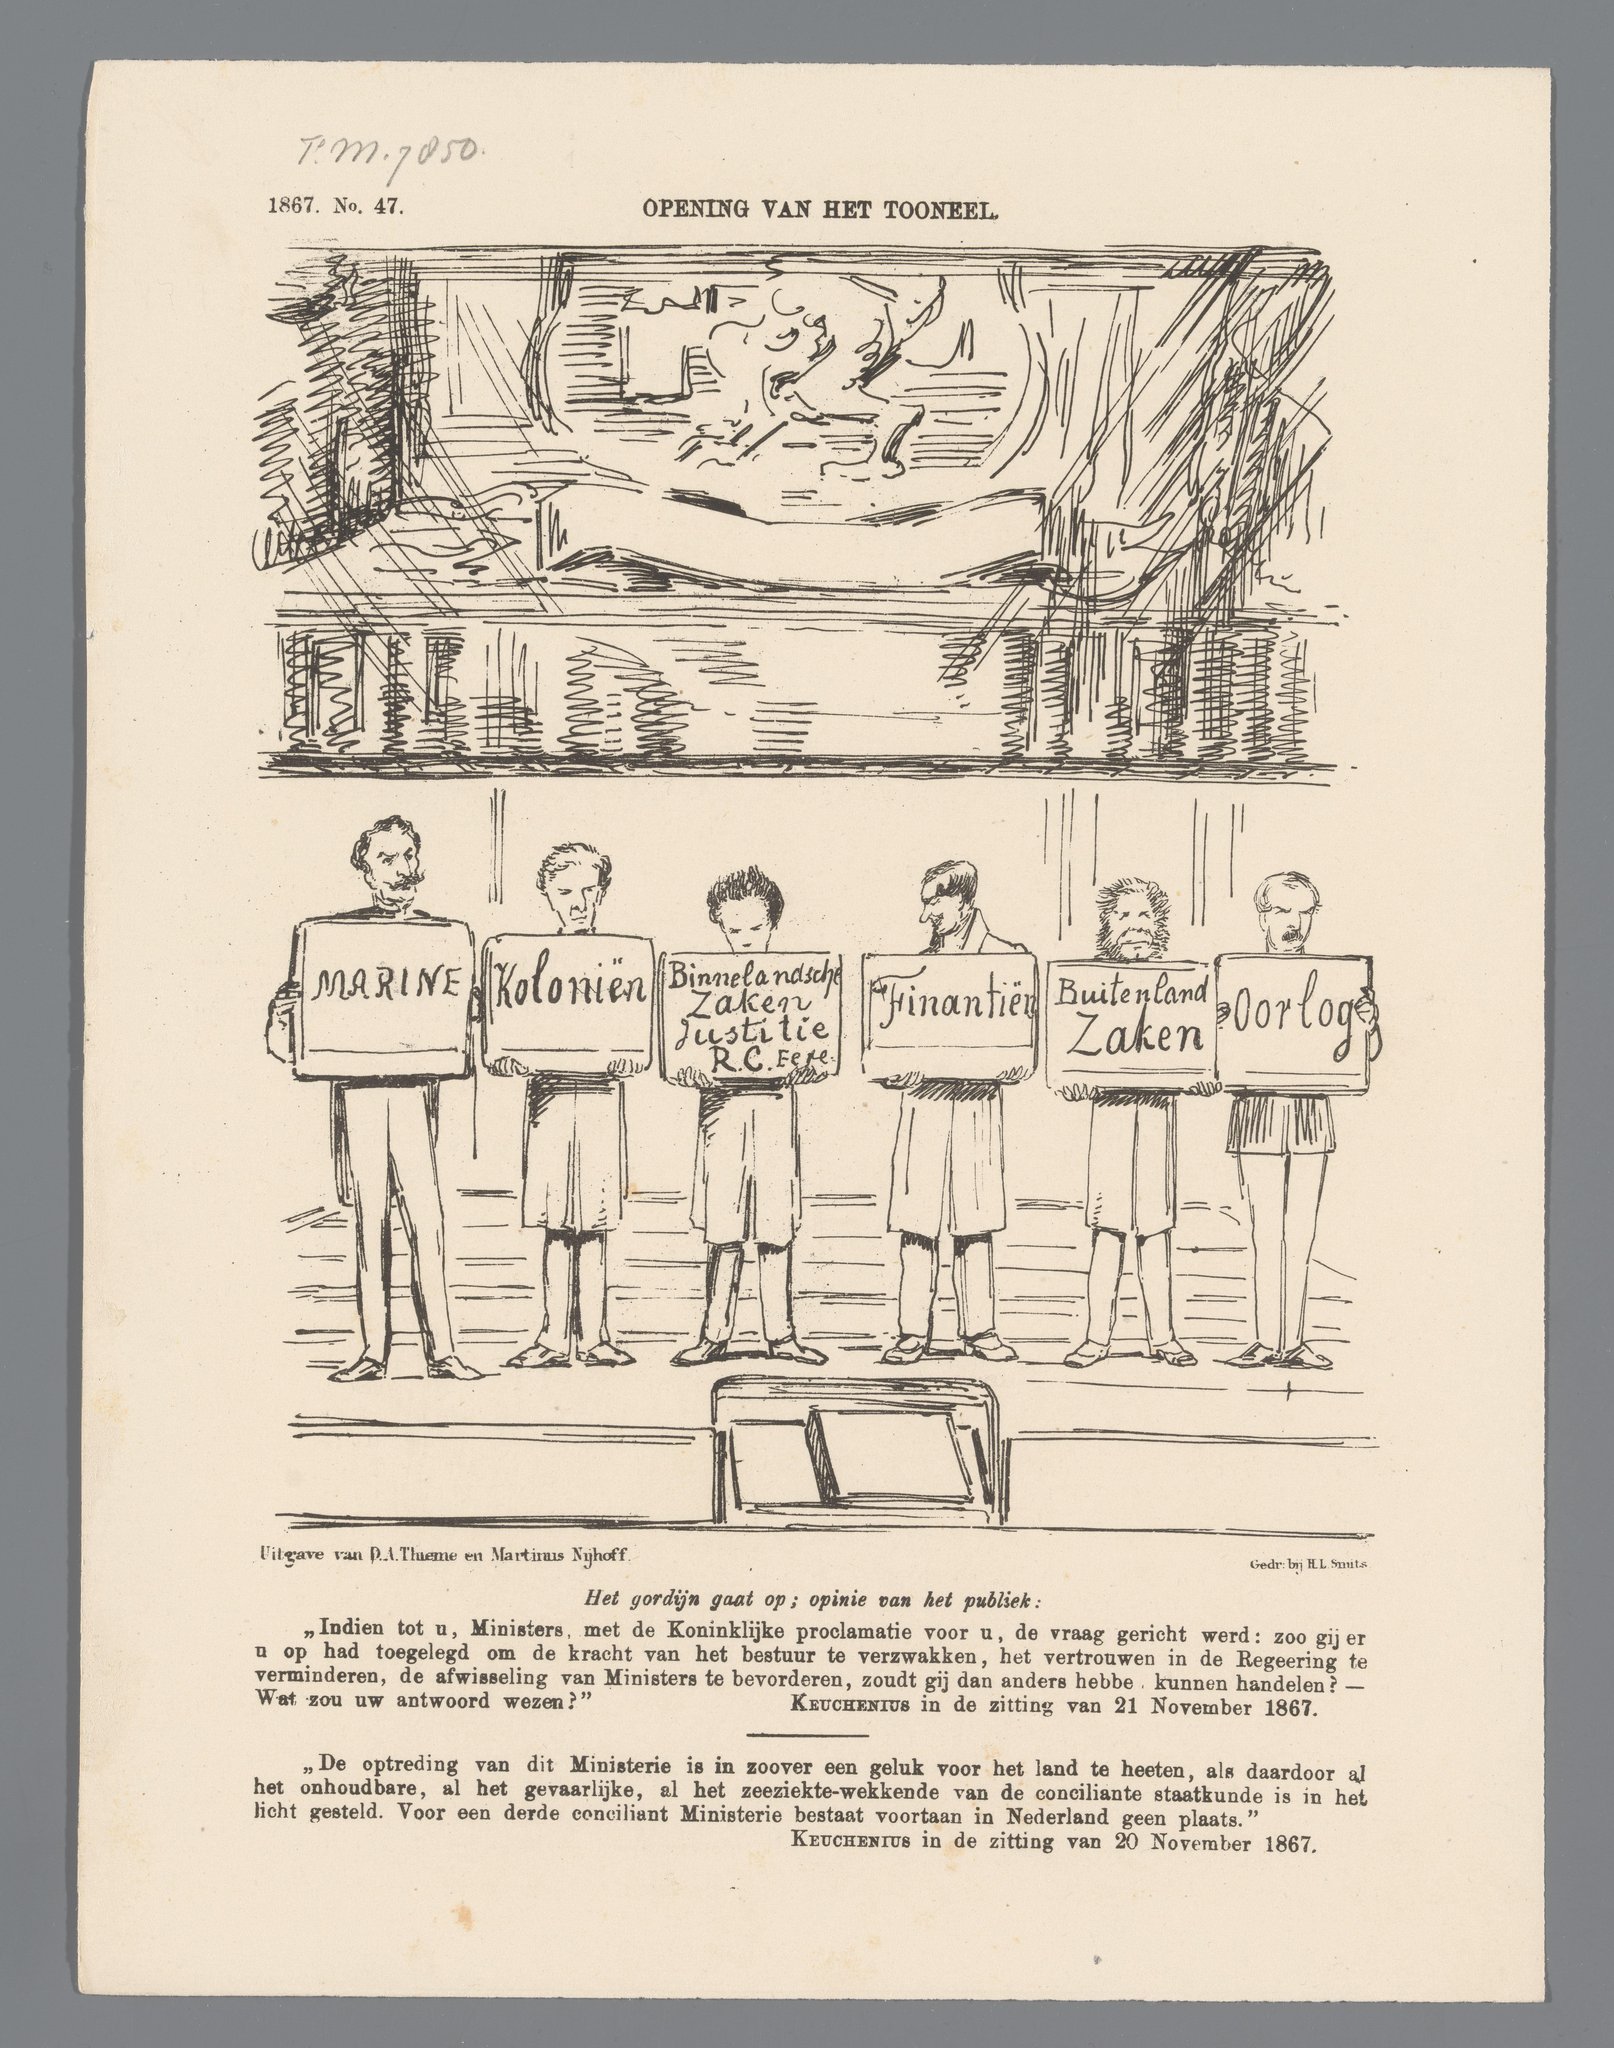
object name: cartoon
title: Opening van het tooneel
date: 1867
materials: paper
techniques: lithograph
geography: arnhem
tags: amsterdam, the hague, politician, minister ~ government, the stage and its equipment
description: Spotprent met de ministers (ministerie Heemskerk) met hun portefeuilles staande op het toneel. Plaat verschenen bij het weekblad De Nederlandsche Spectator, nr. 46, 16 november 1867.